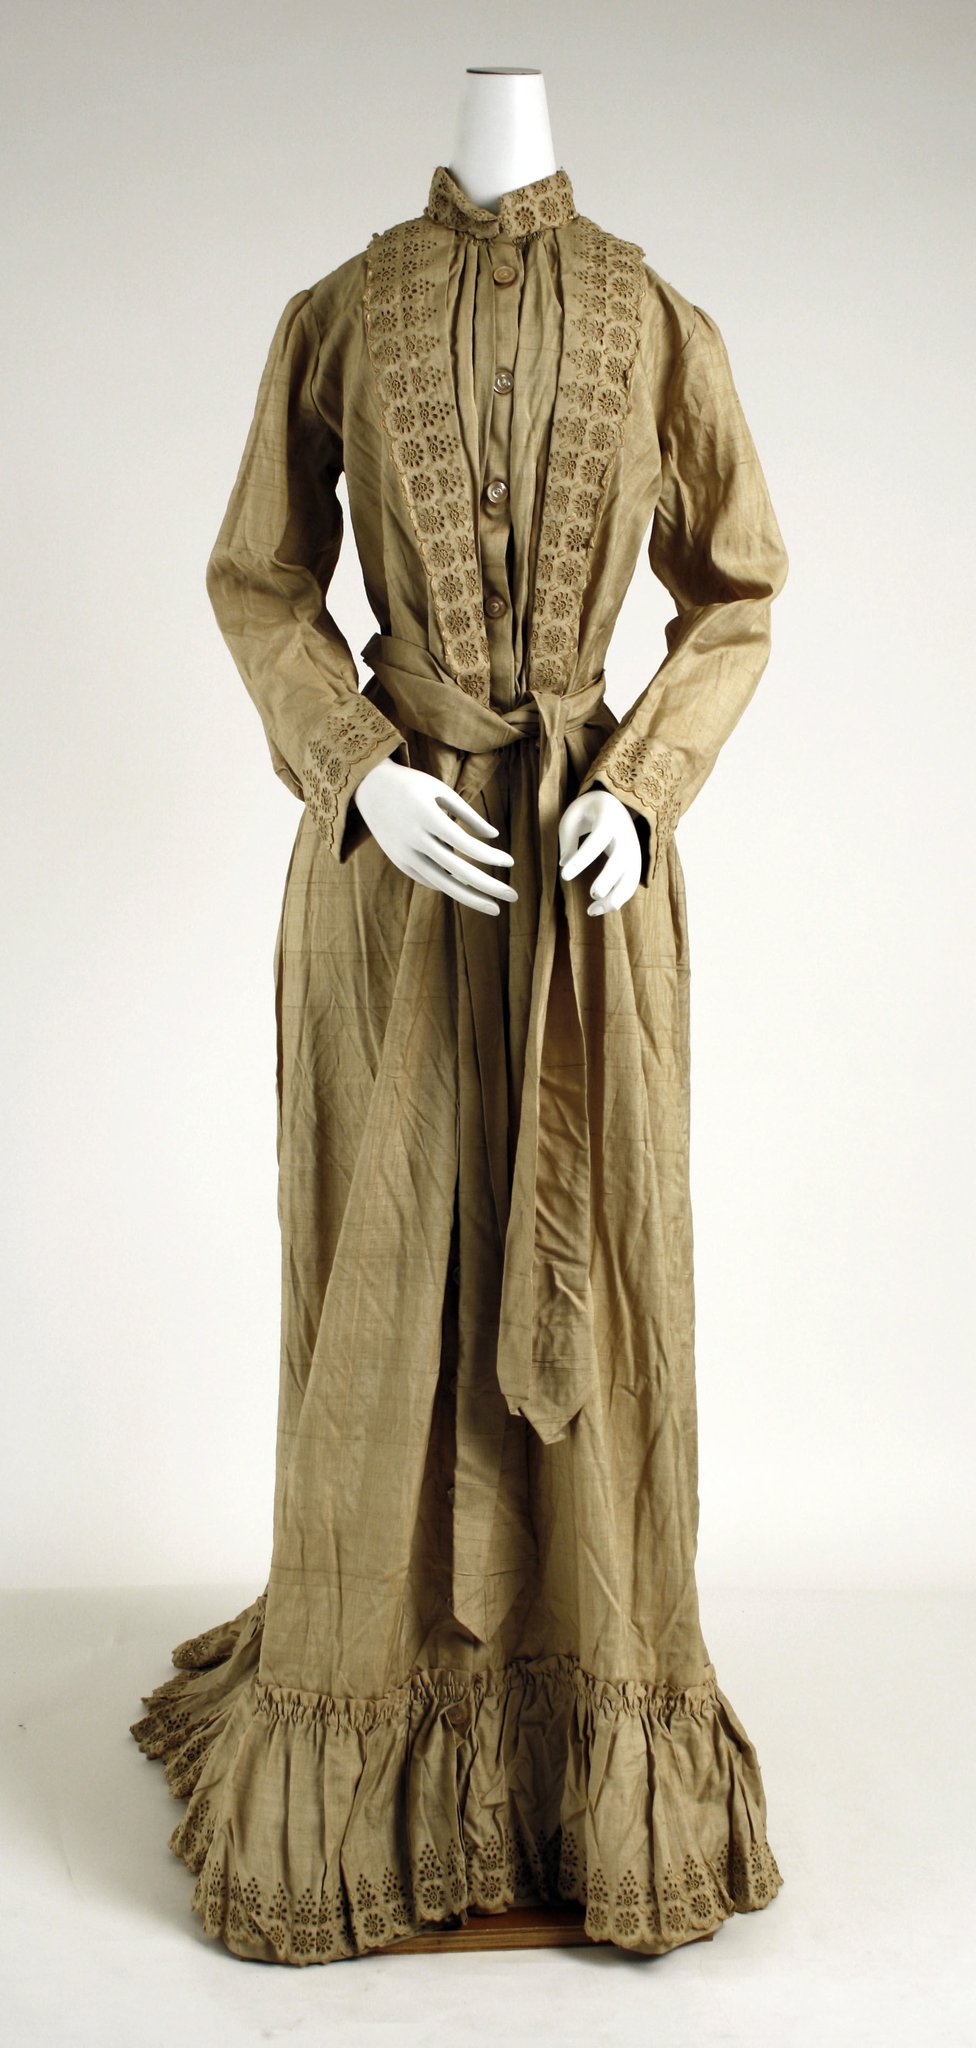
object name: negligée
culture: american or european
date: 1888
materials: silk